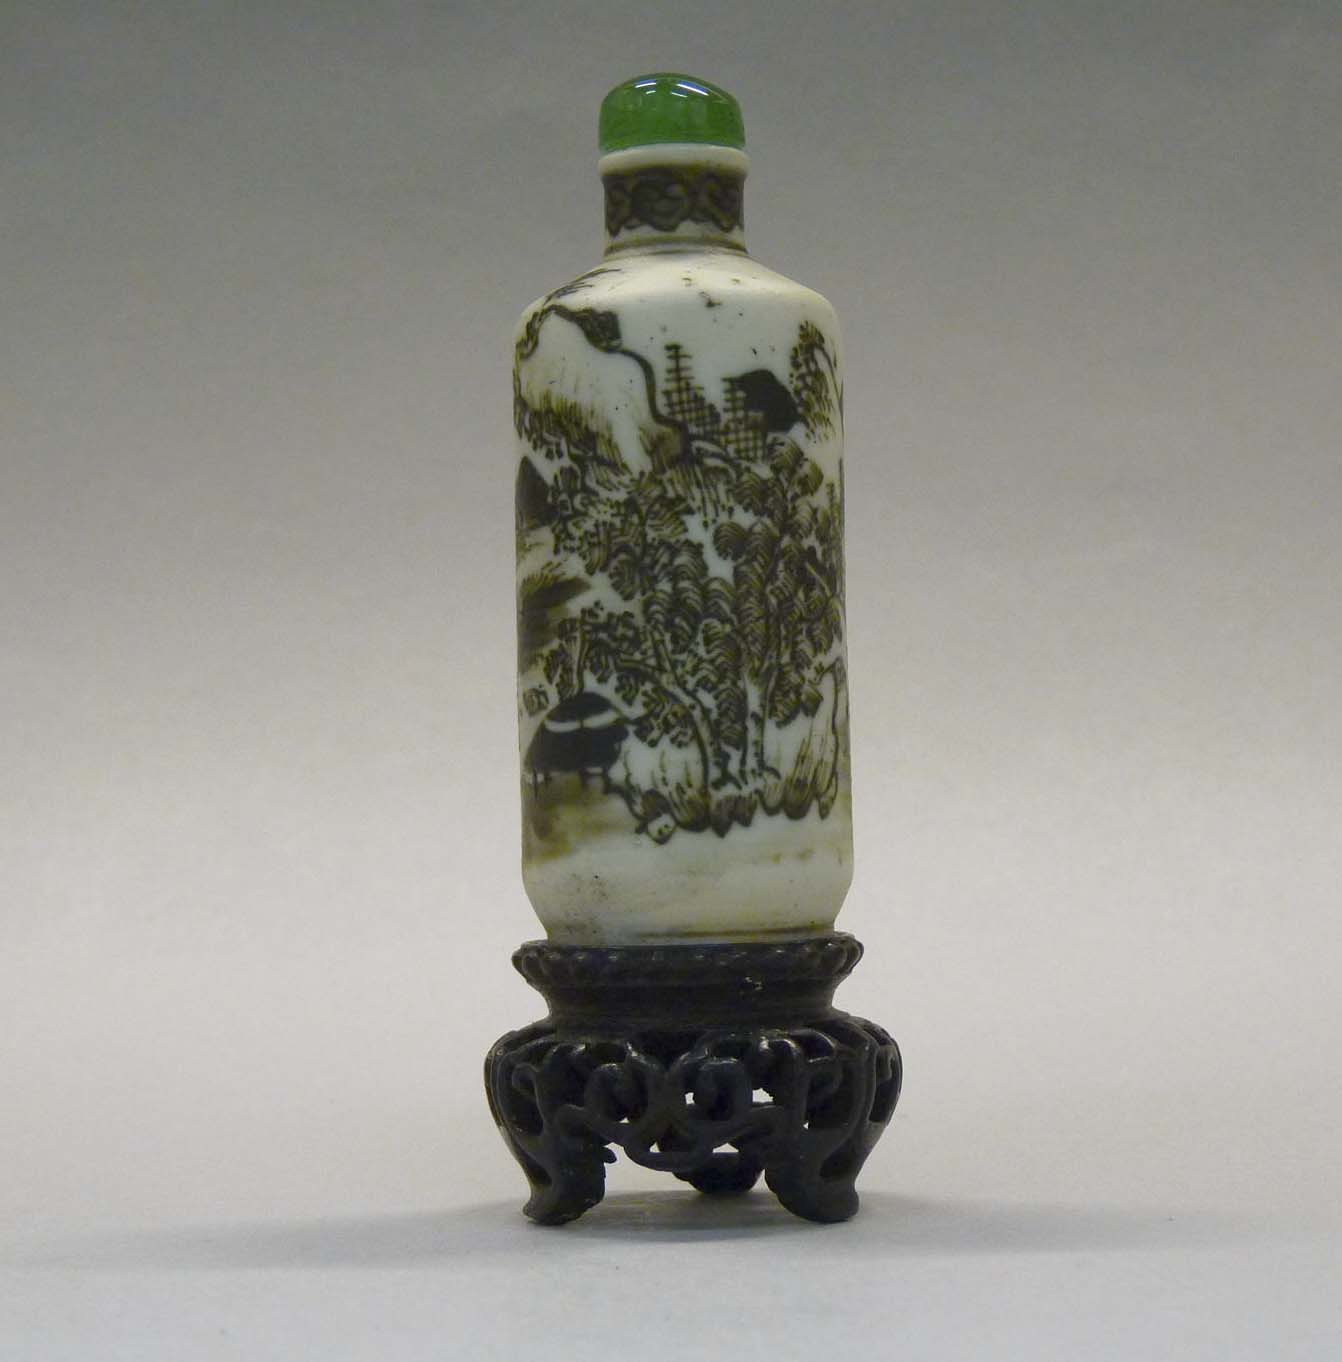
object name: snuff bottle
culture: chinese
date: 1900-1920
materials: biscuit, enamel, glass, porcelain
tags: landscapes